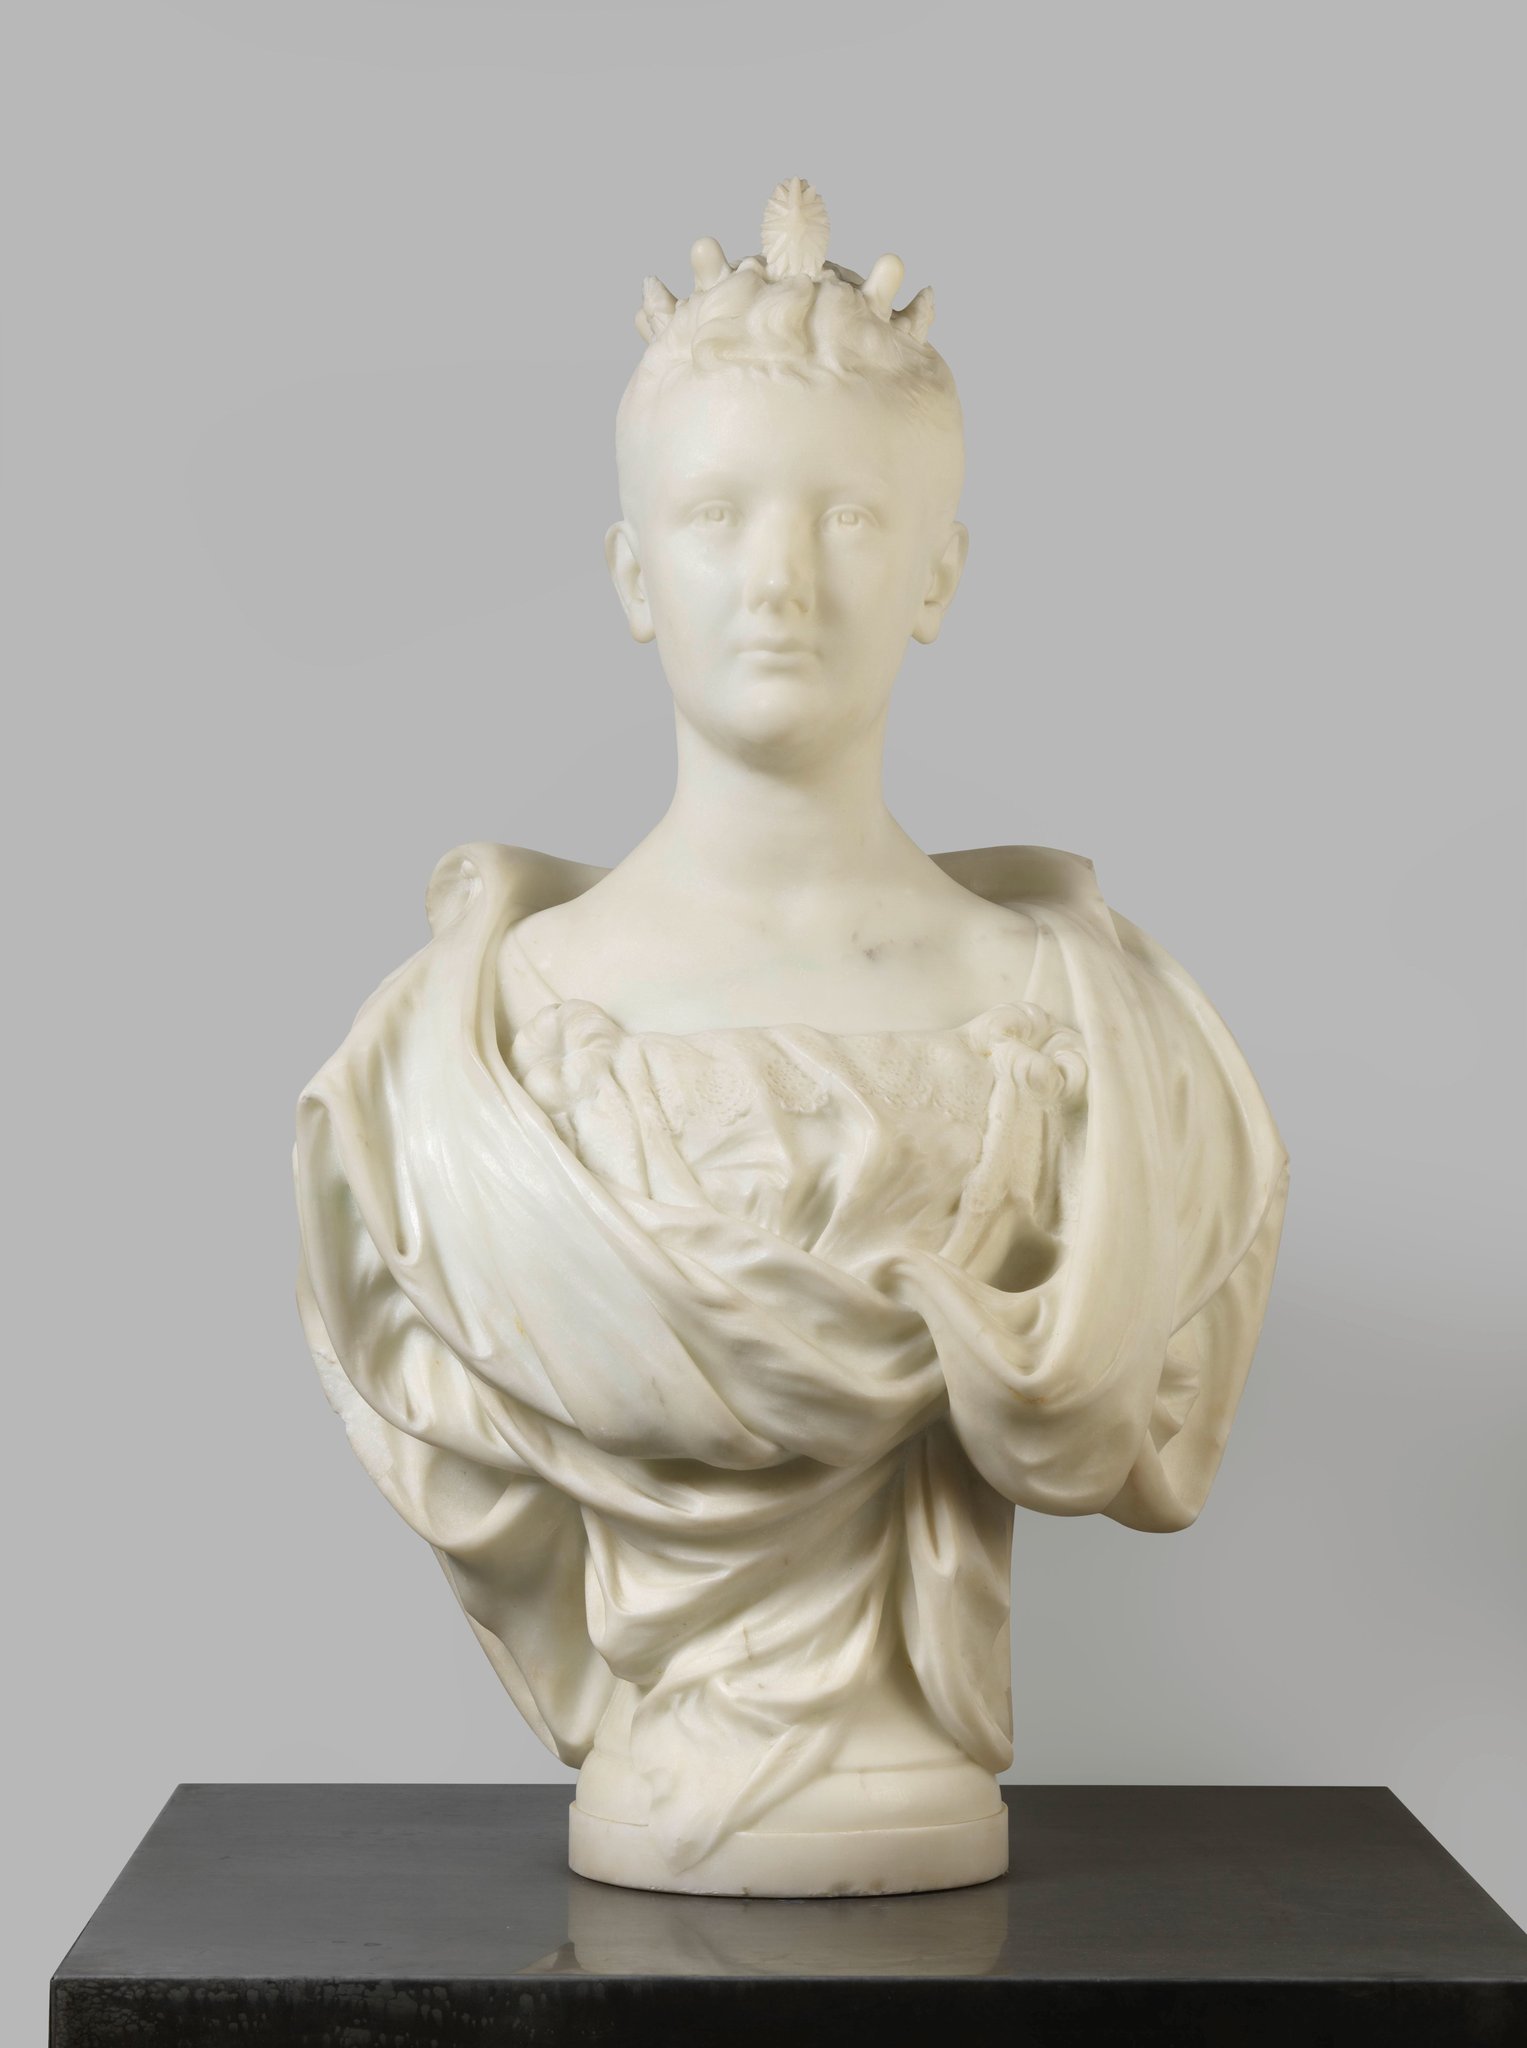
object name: sculpture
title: Borstbeeld van koningin Wilhelmina (1880-1962)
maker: bart van hove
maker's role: sculptor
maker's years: 1850-1914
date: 1898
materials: marble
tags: print maker, wilhelmina of the netherlands